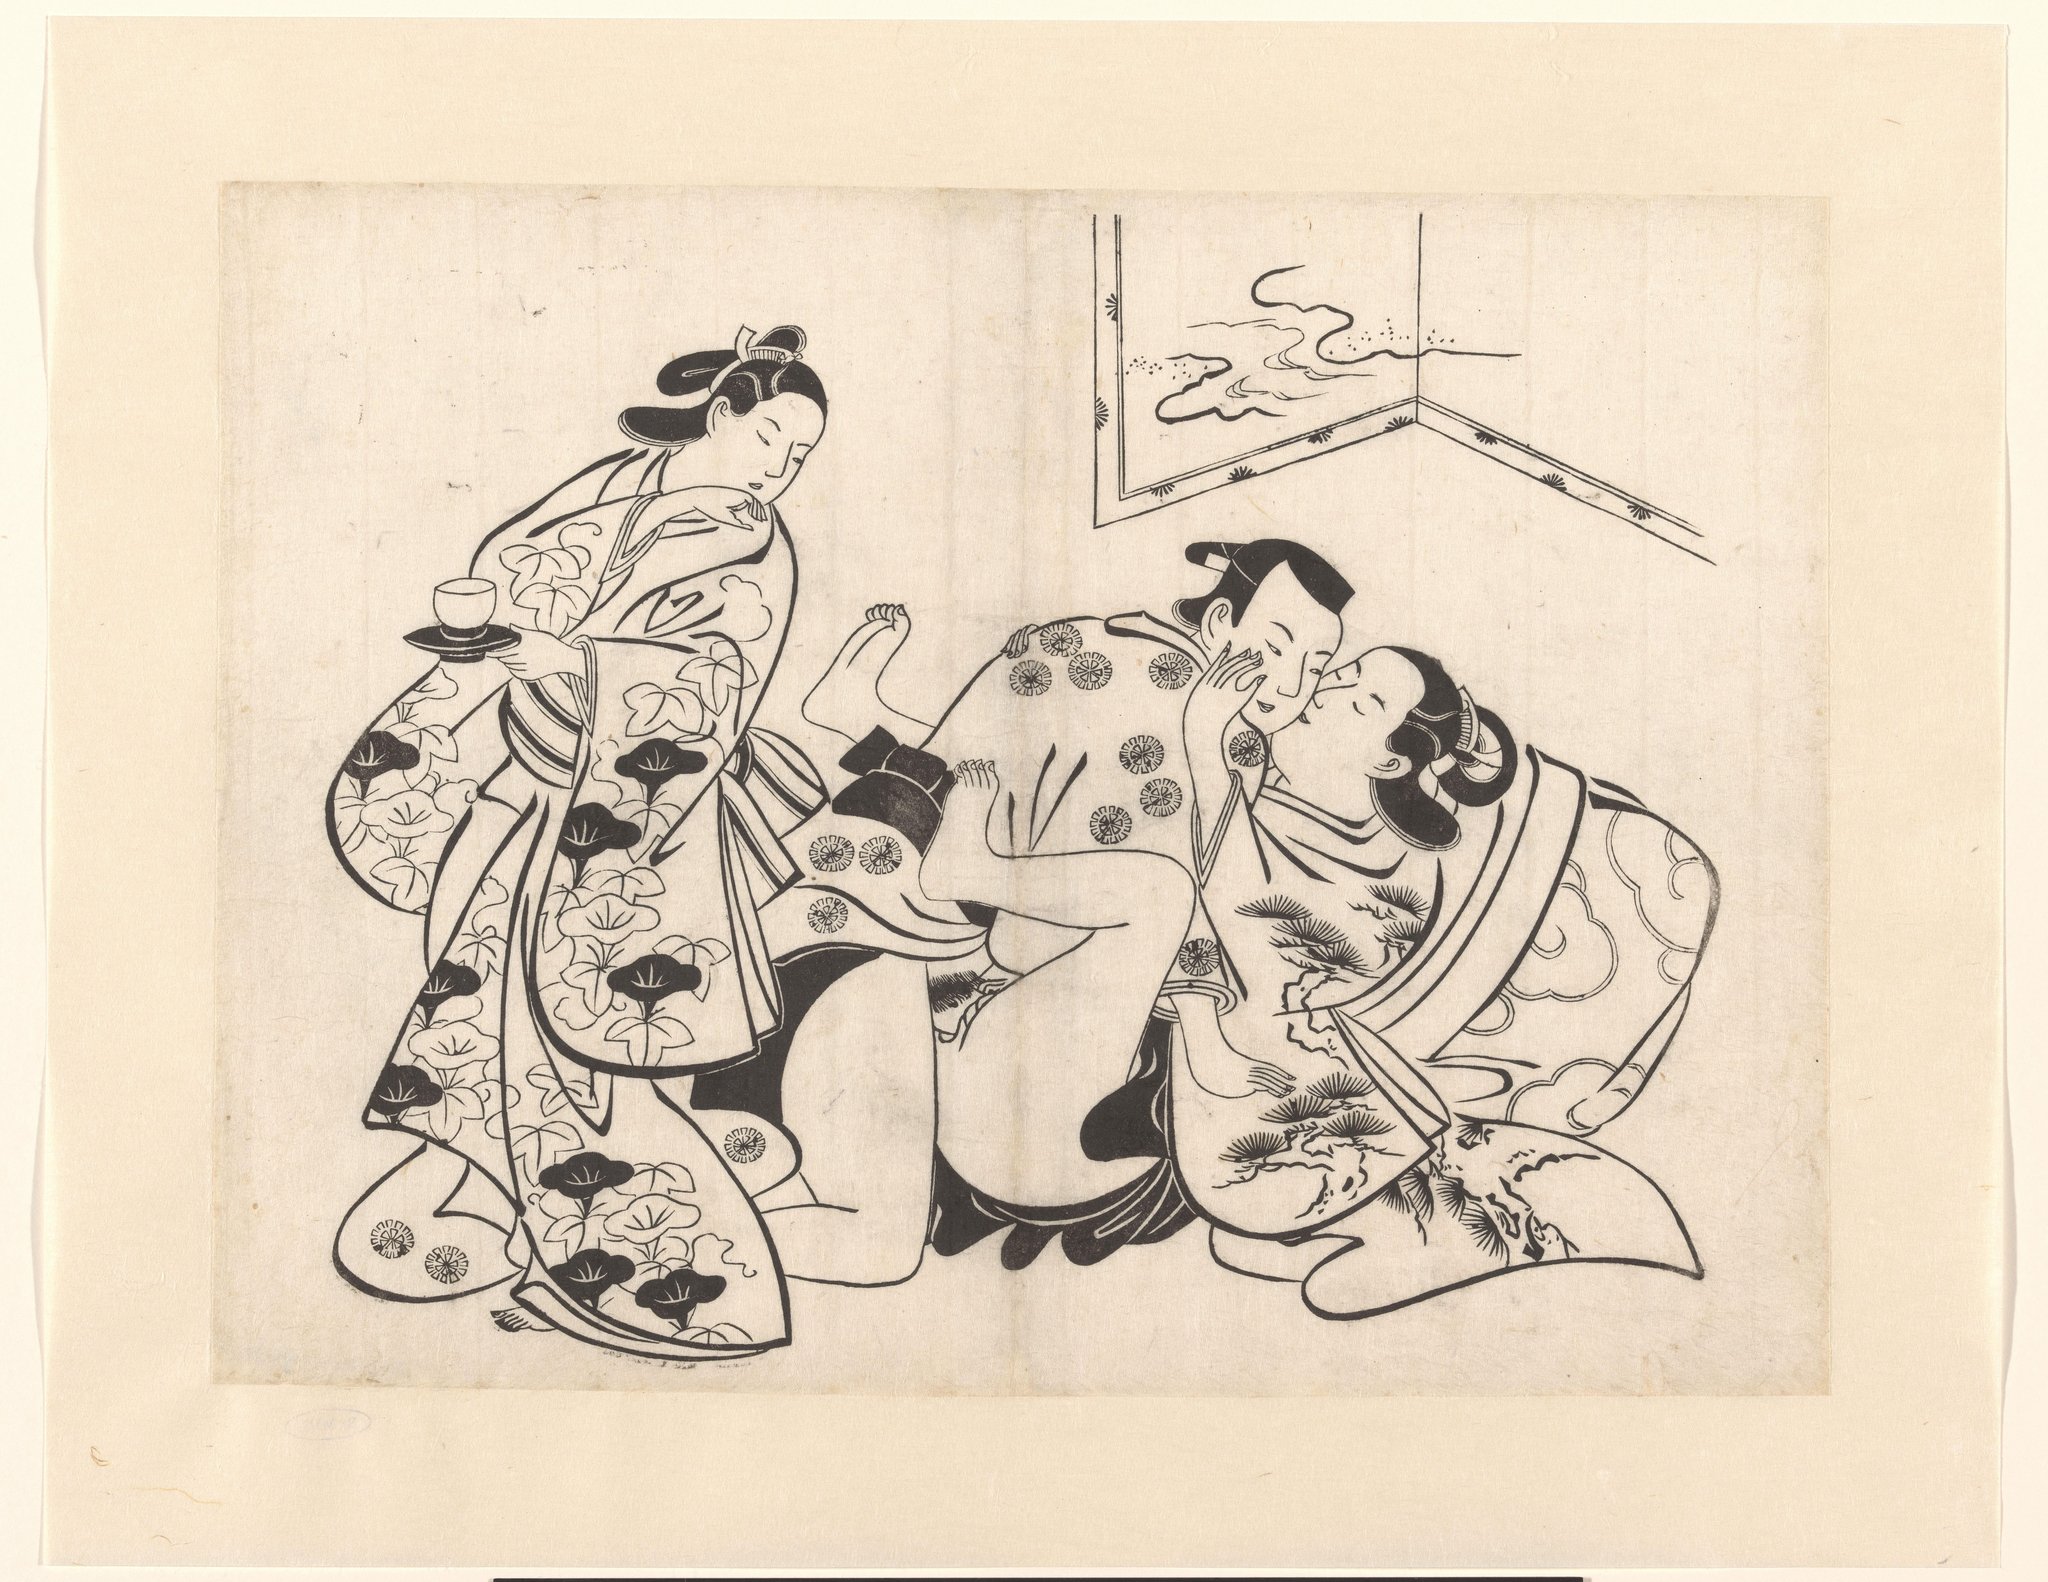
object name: shunga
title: Vrijend paar met omkijkend meisje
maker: torii kiyonobu (i)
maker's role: print maker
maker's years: 1664-1729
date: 1690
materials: paper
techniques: hand coloring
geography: japan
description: Meisje met een theekopje in haar hand kijkt om naar een vrijend paar. Op de achtergrond een kamerscherm.